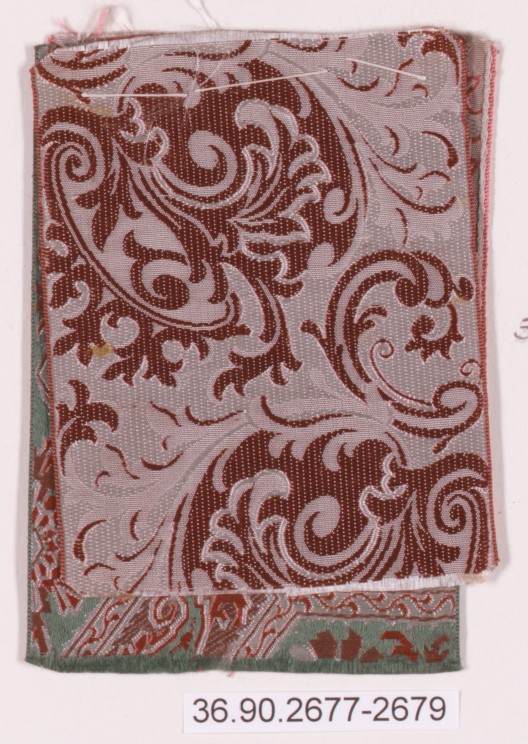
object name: ribbon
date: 1801-1900